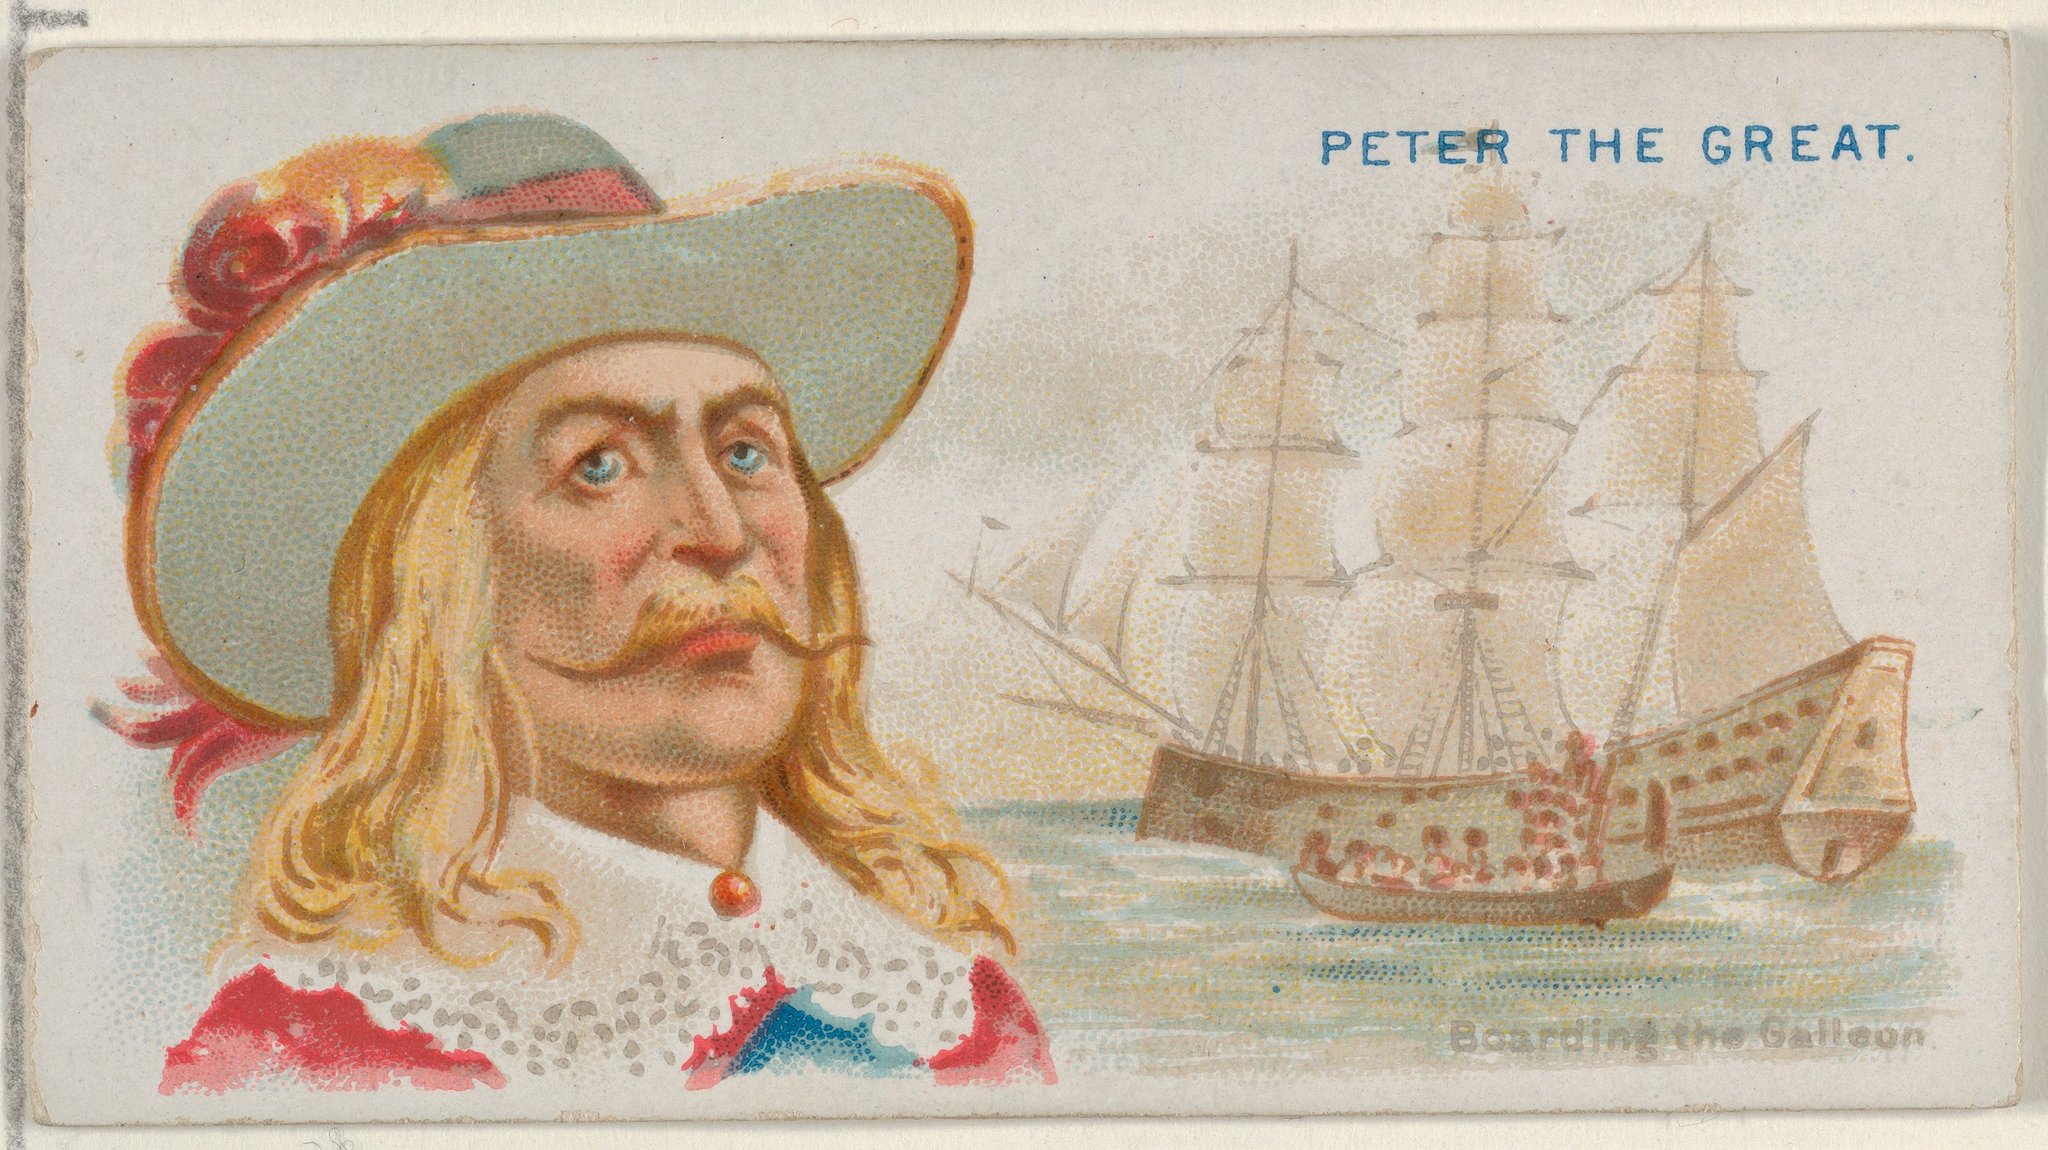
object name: print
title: Jack Avery, Capturing Ship of the Great Mogul, from the Pirates of the Spanish Main series (N19) for Allen & Ginter Cigarettes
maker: allen & ginter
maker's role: publisher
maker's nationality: american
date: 1888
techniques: color lithograph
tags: men,ships